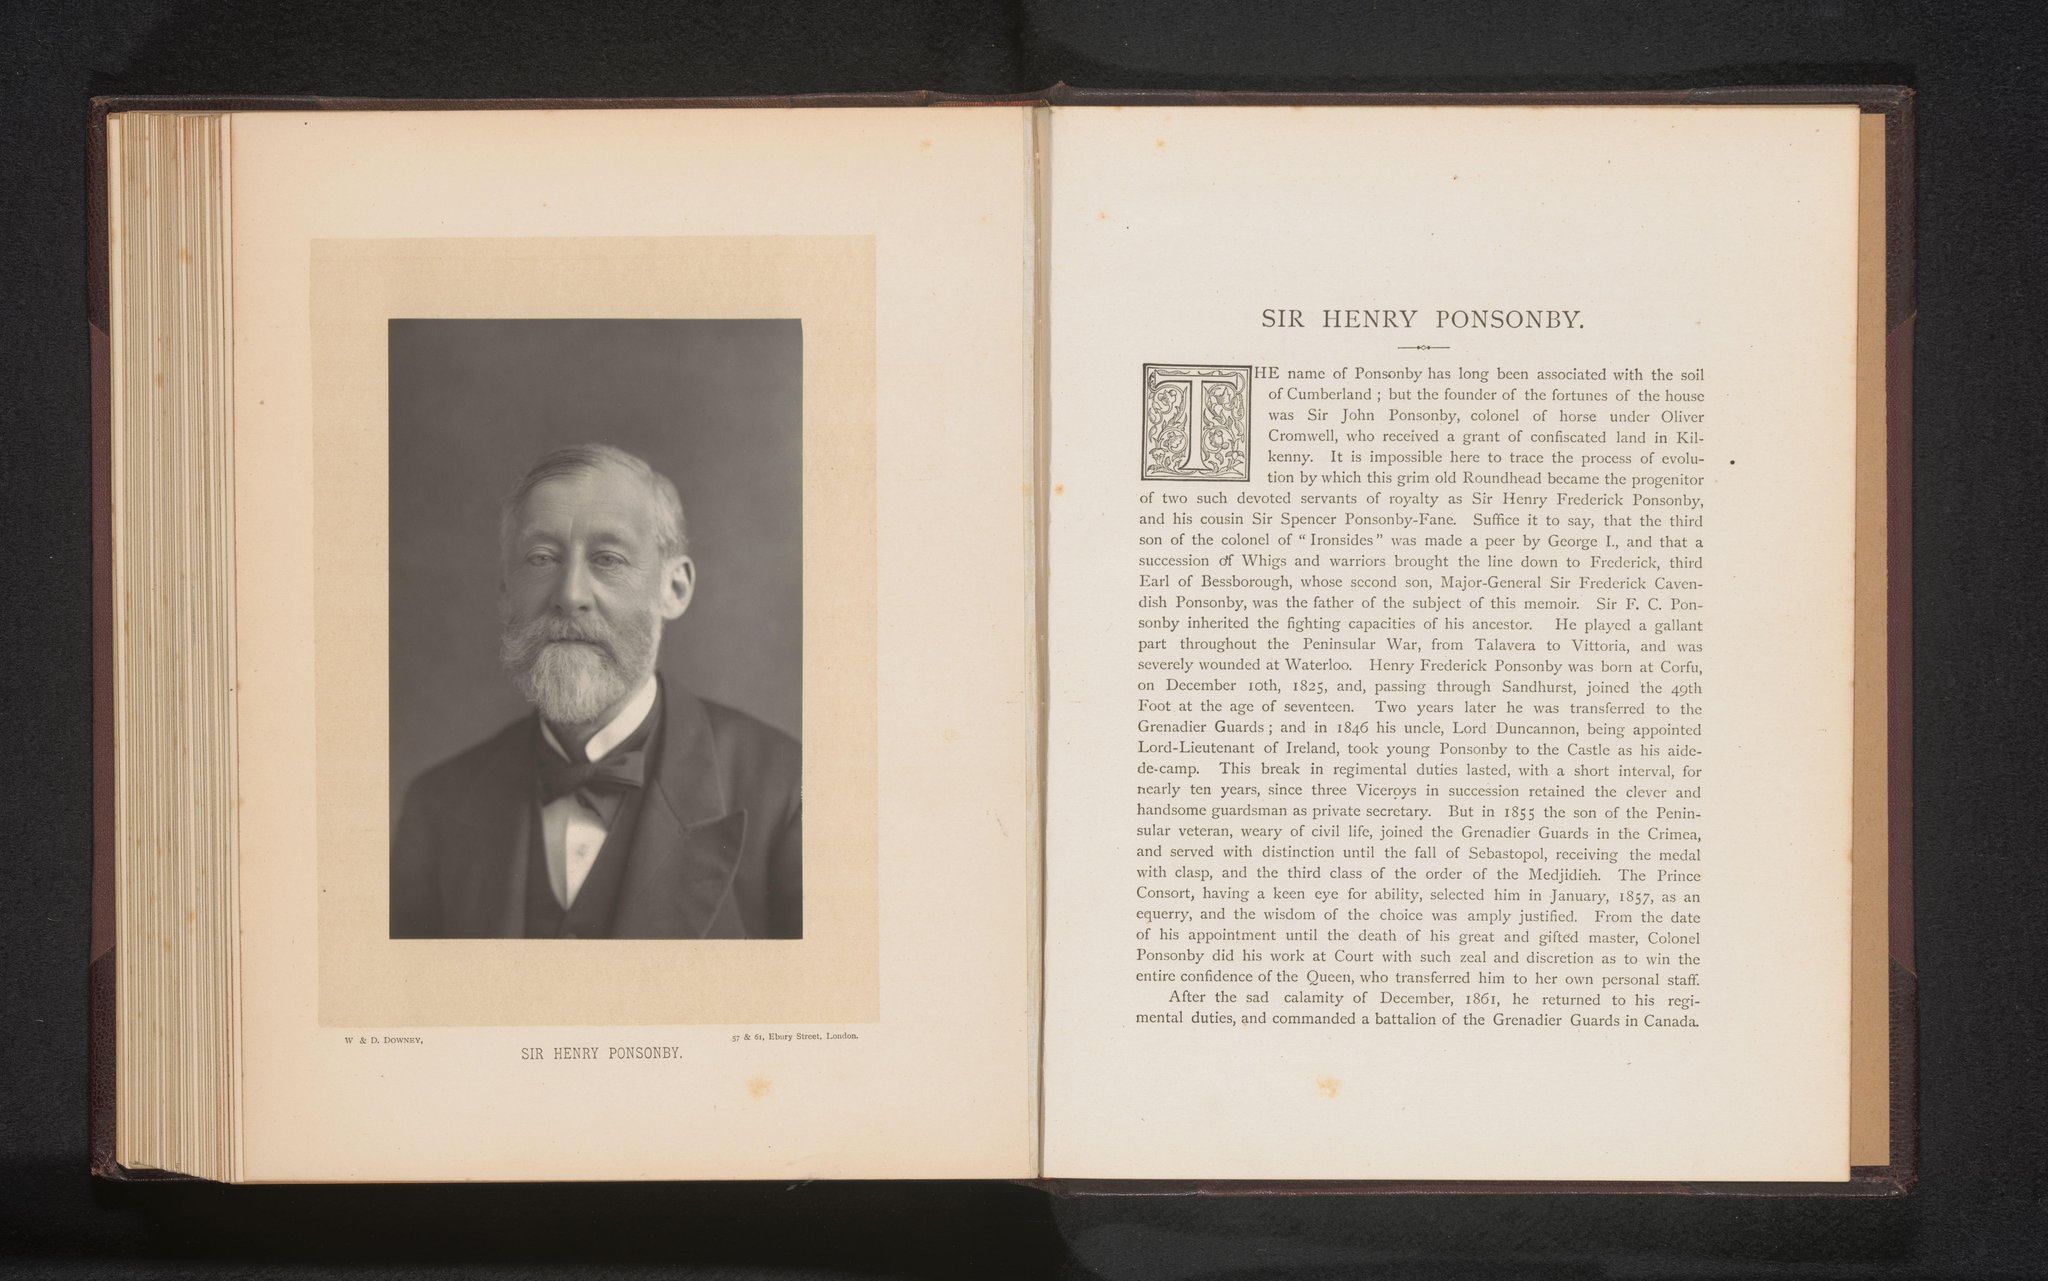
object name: page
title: Sir Henry Ponsonby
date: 1885-1890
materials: paper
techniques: carbon print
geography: london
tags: historical persons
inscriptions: address: ‘57 & 61, Ebury Street, London.’